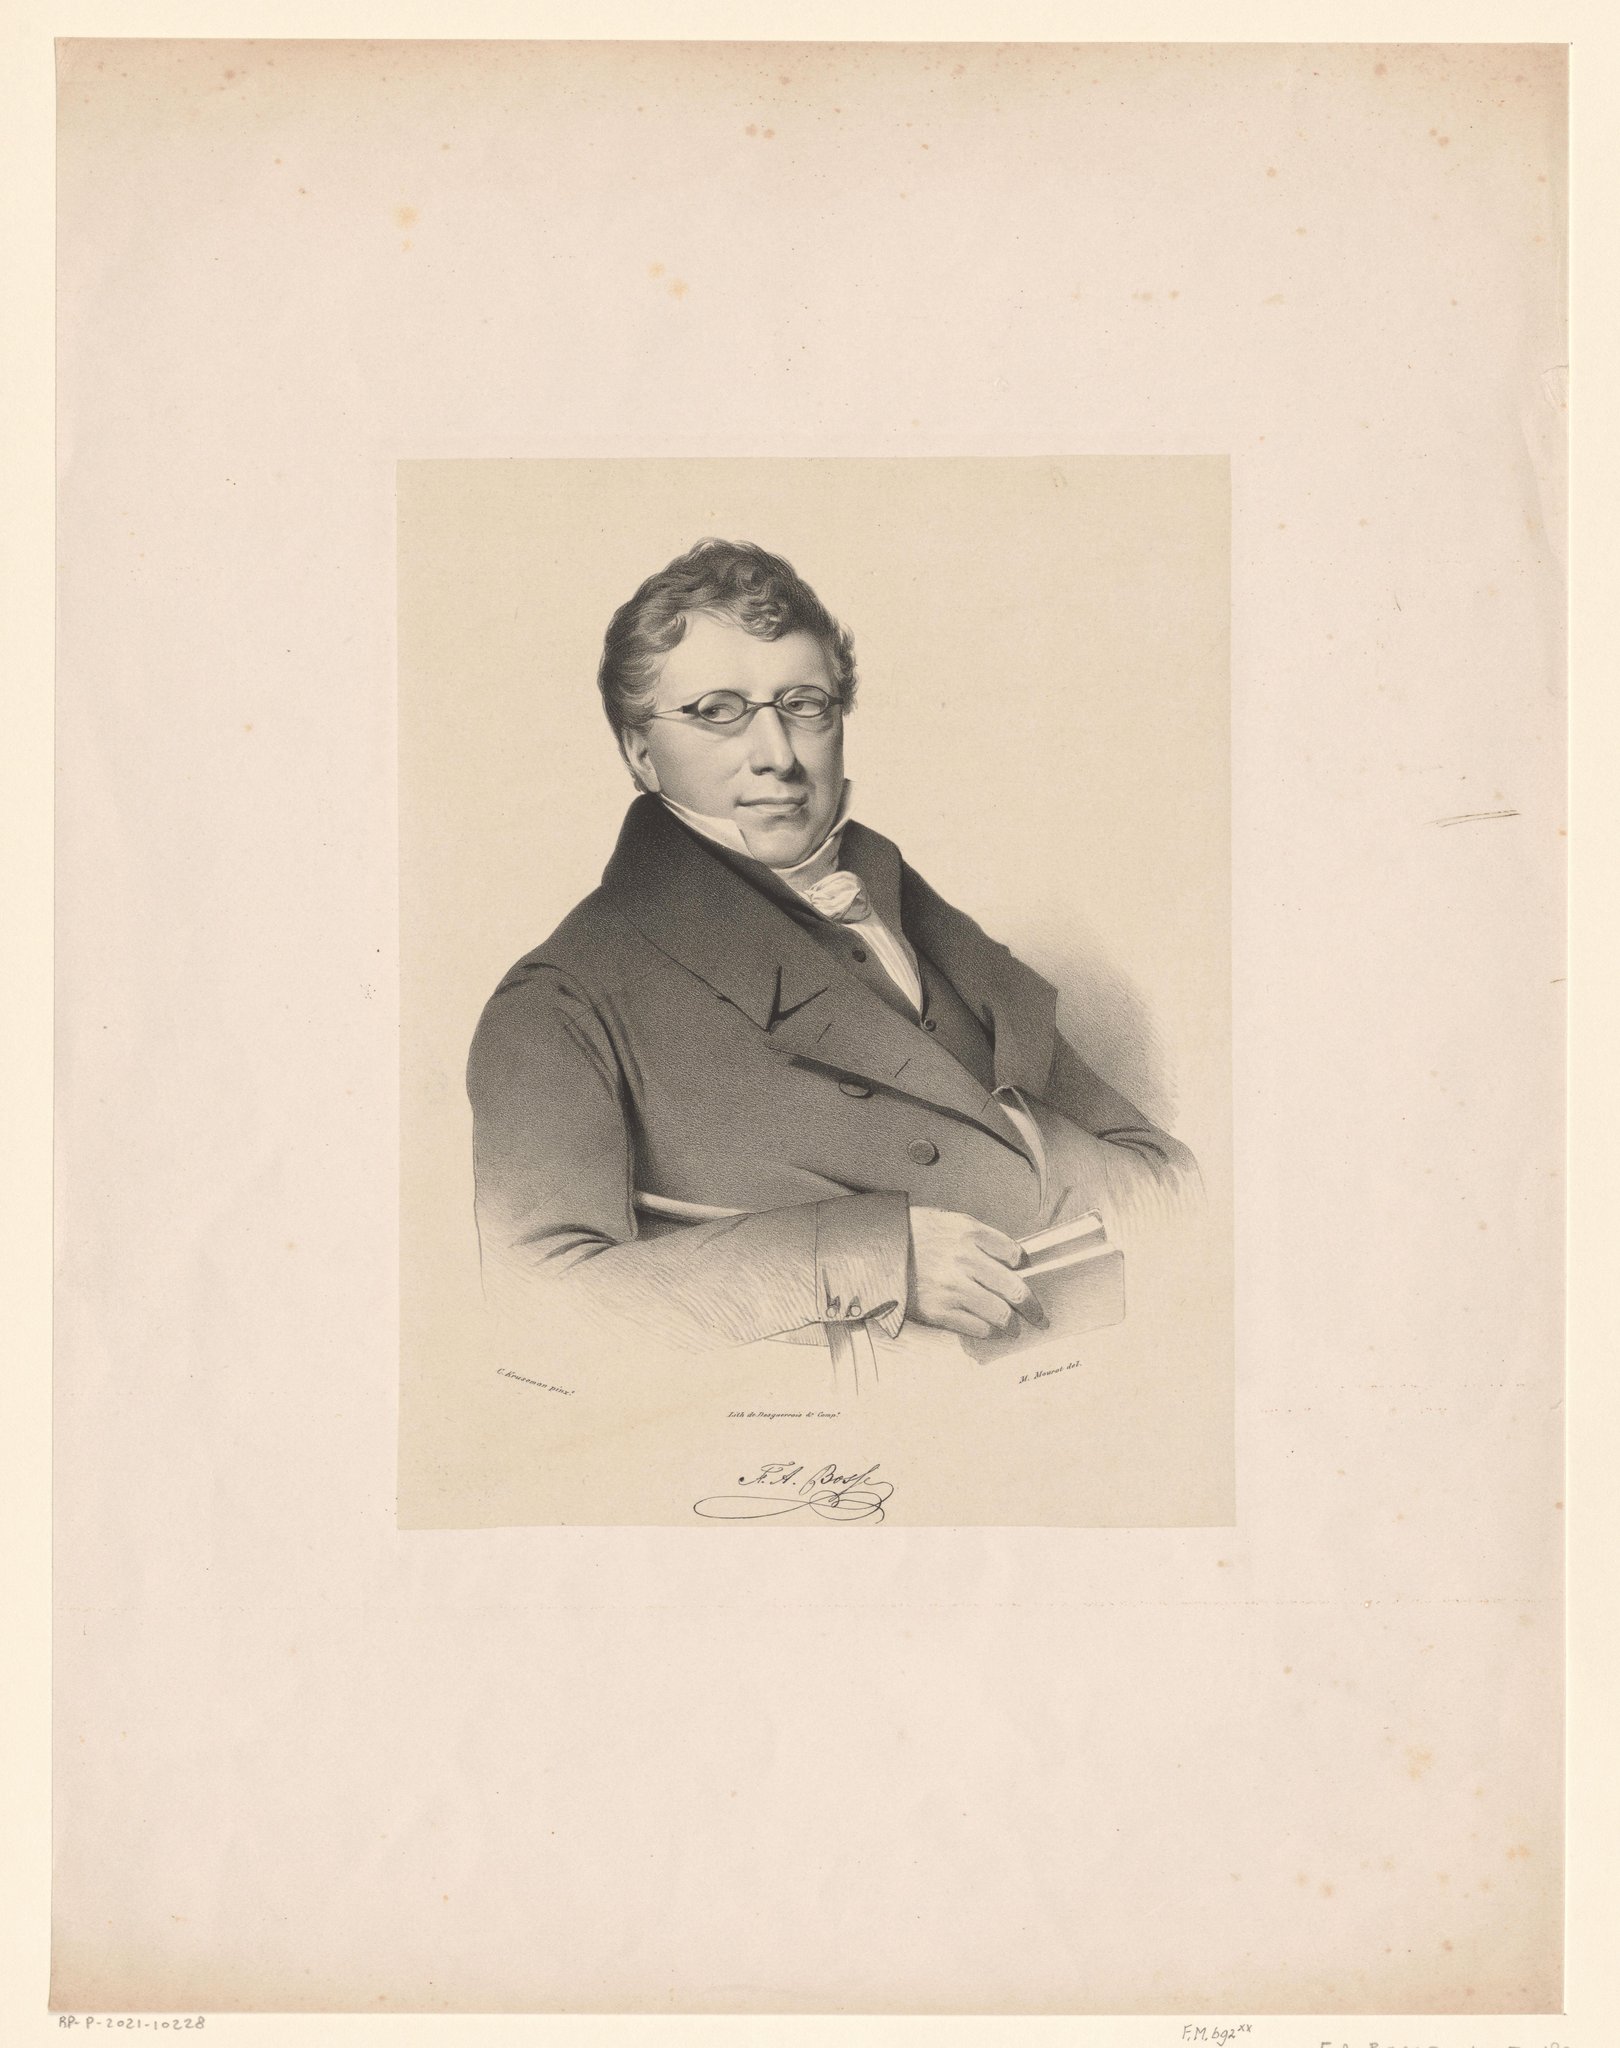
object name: print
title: Portret van Frans Antonie Bosse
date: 1826-1847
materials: paper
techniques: lithograph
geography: amsterdam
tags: amsterdam, eyeglasses, spectacles, historical persons, armorial bearing, heraldry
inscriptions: collector's mark: Lugt 2228